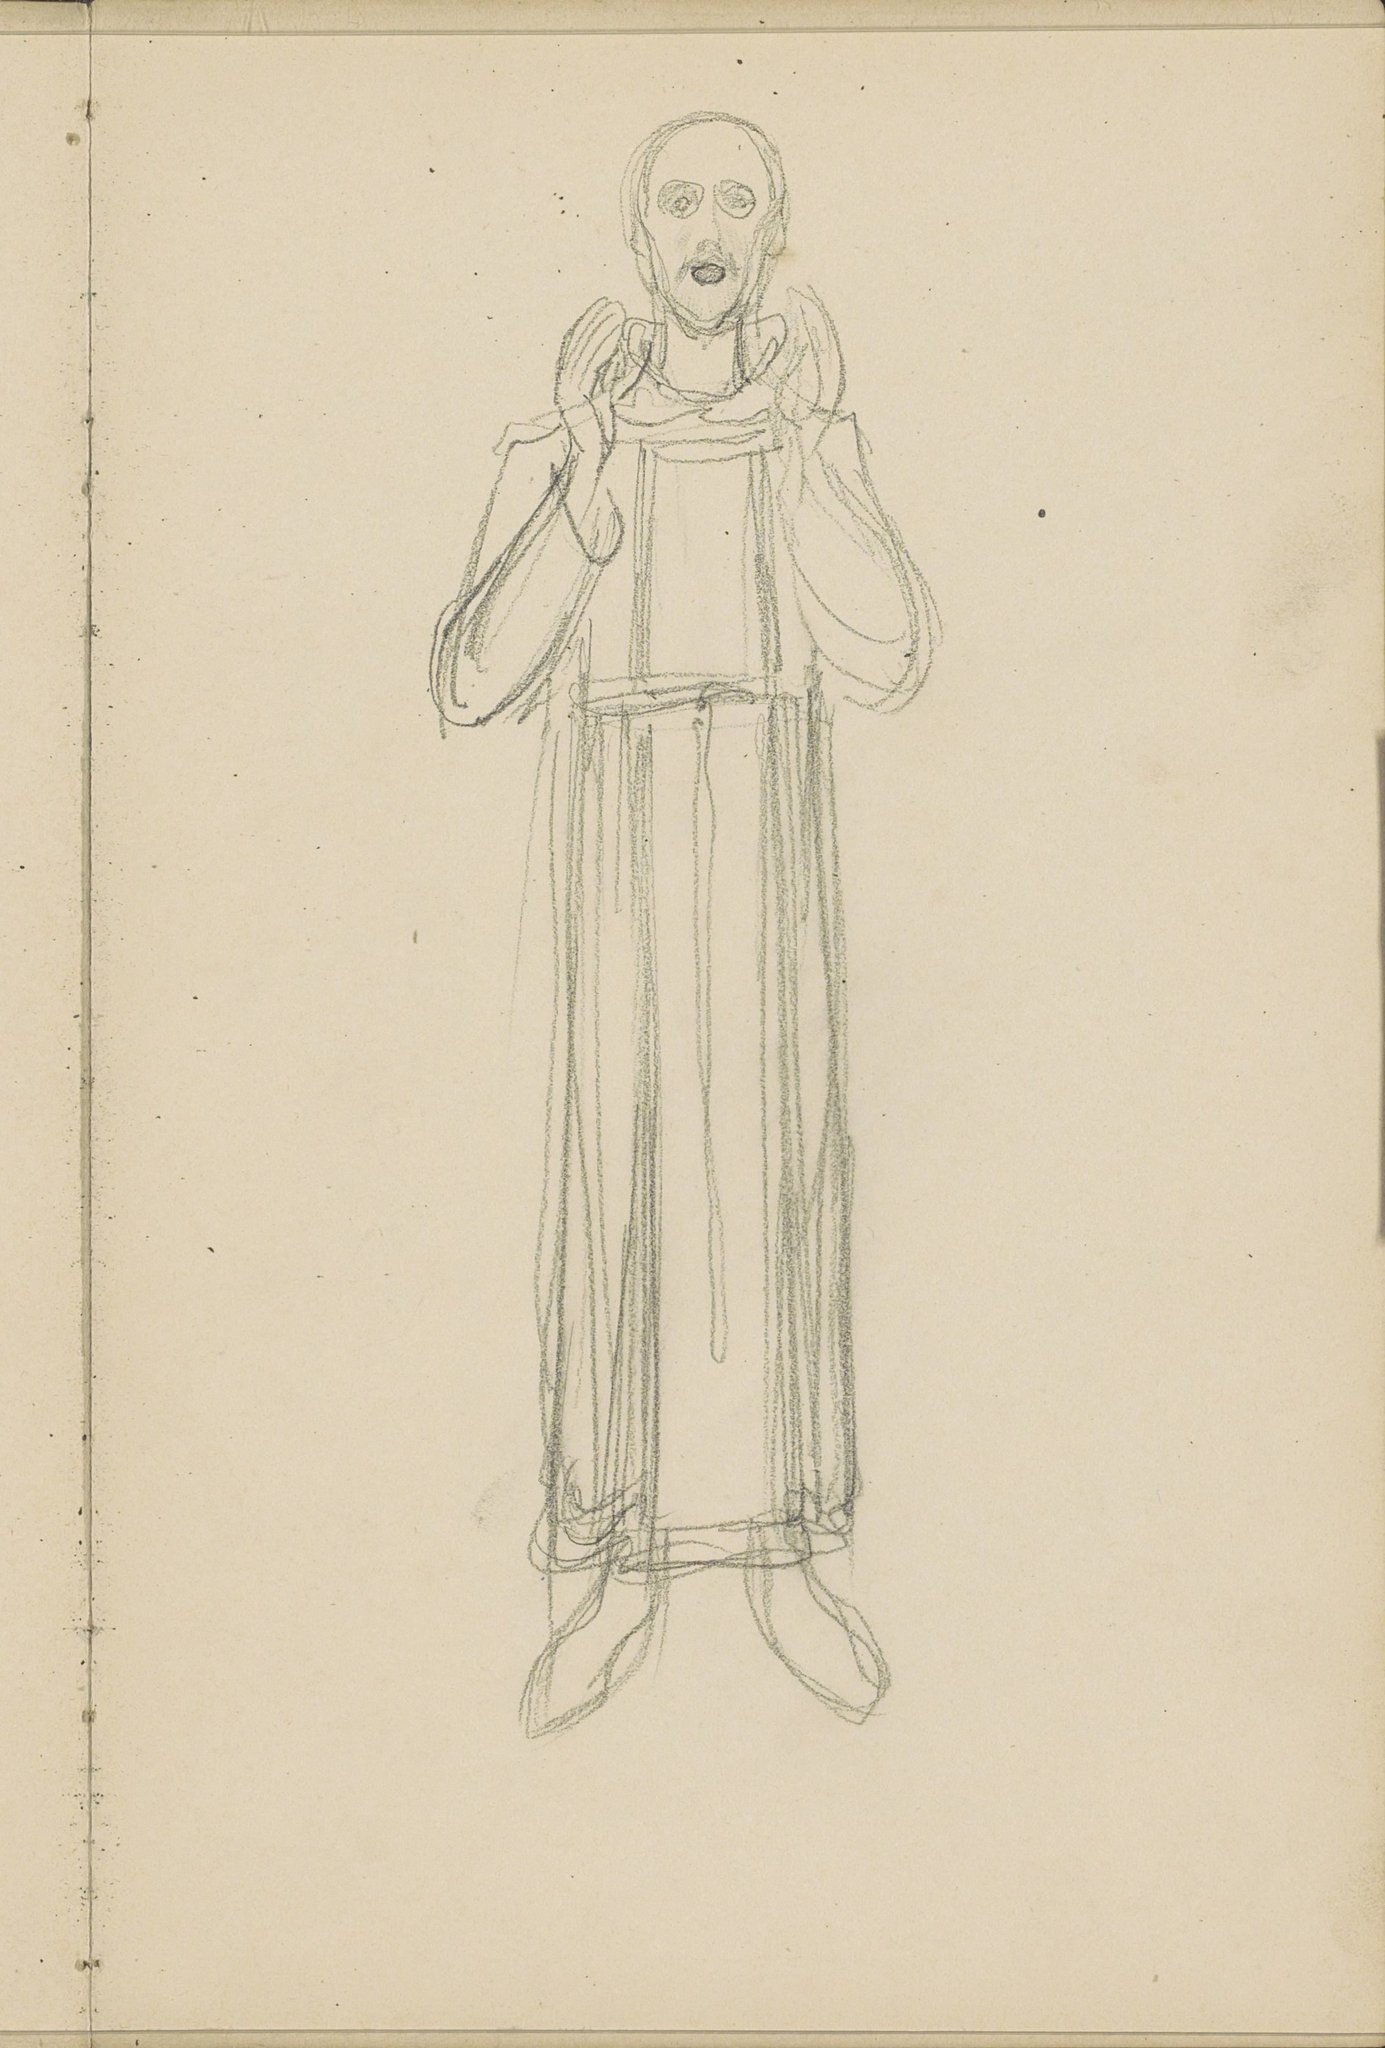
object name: sketchbook leaf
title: Staande kloosterling met opgeheven armen en opengesperde mond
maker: antoon derkinderen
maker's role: draughtsman, painter, print maker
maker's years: 1859-1925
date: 1889-1891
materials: paper, pencil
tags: mouth wide open, arm raised upward, monk(s), friar(s)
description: Mogelijk een voorstudie voor Derkinderens wandschildering in het stadhuis te Den Bosch. Blad 28 recto uit een schetsboek met 33 bladen.